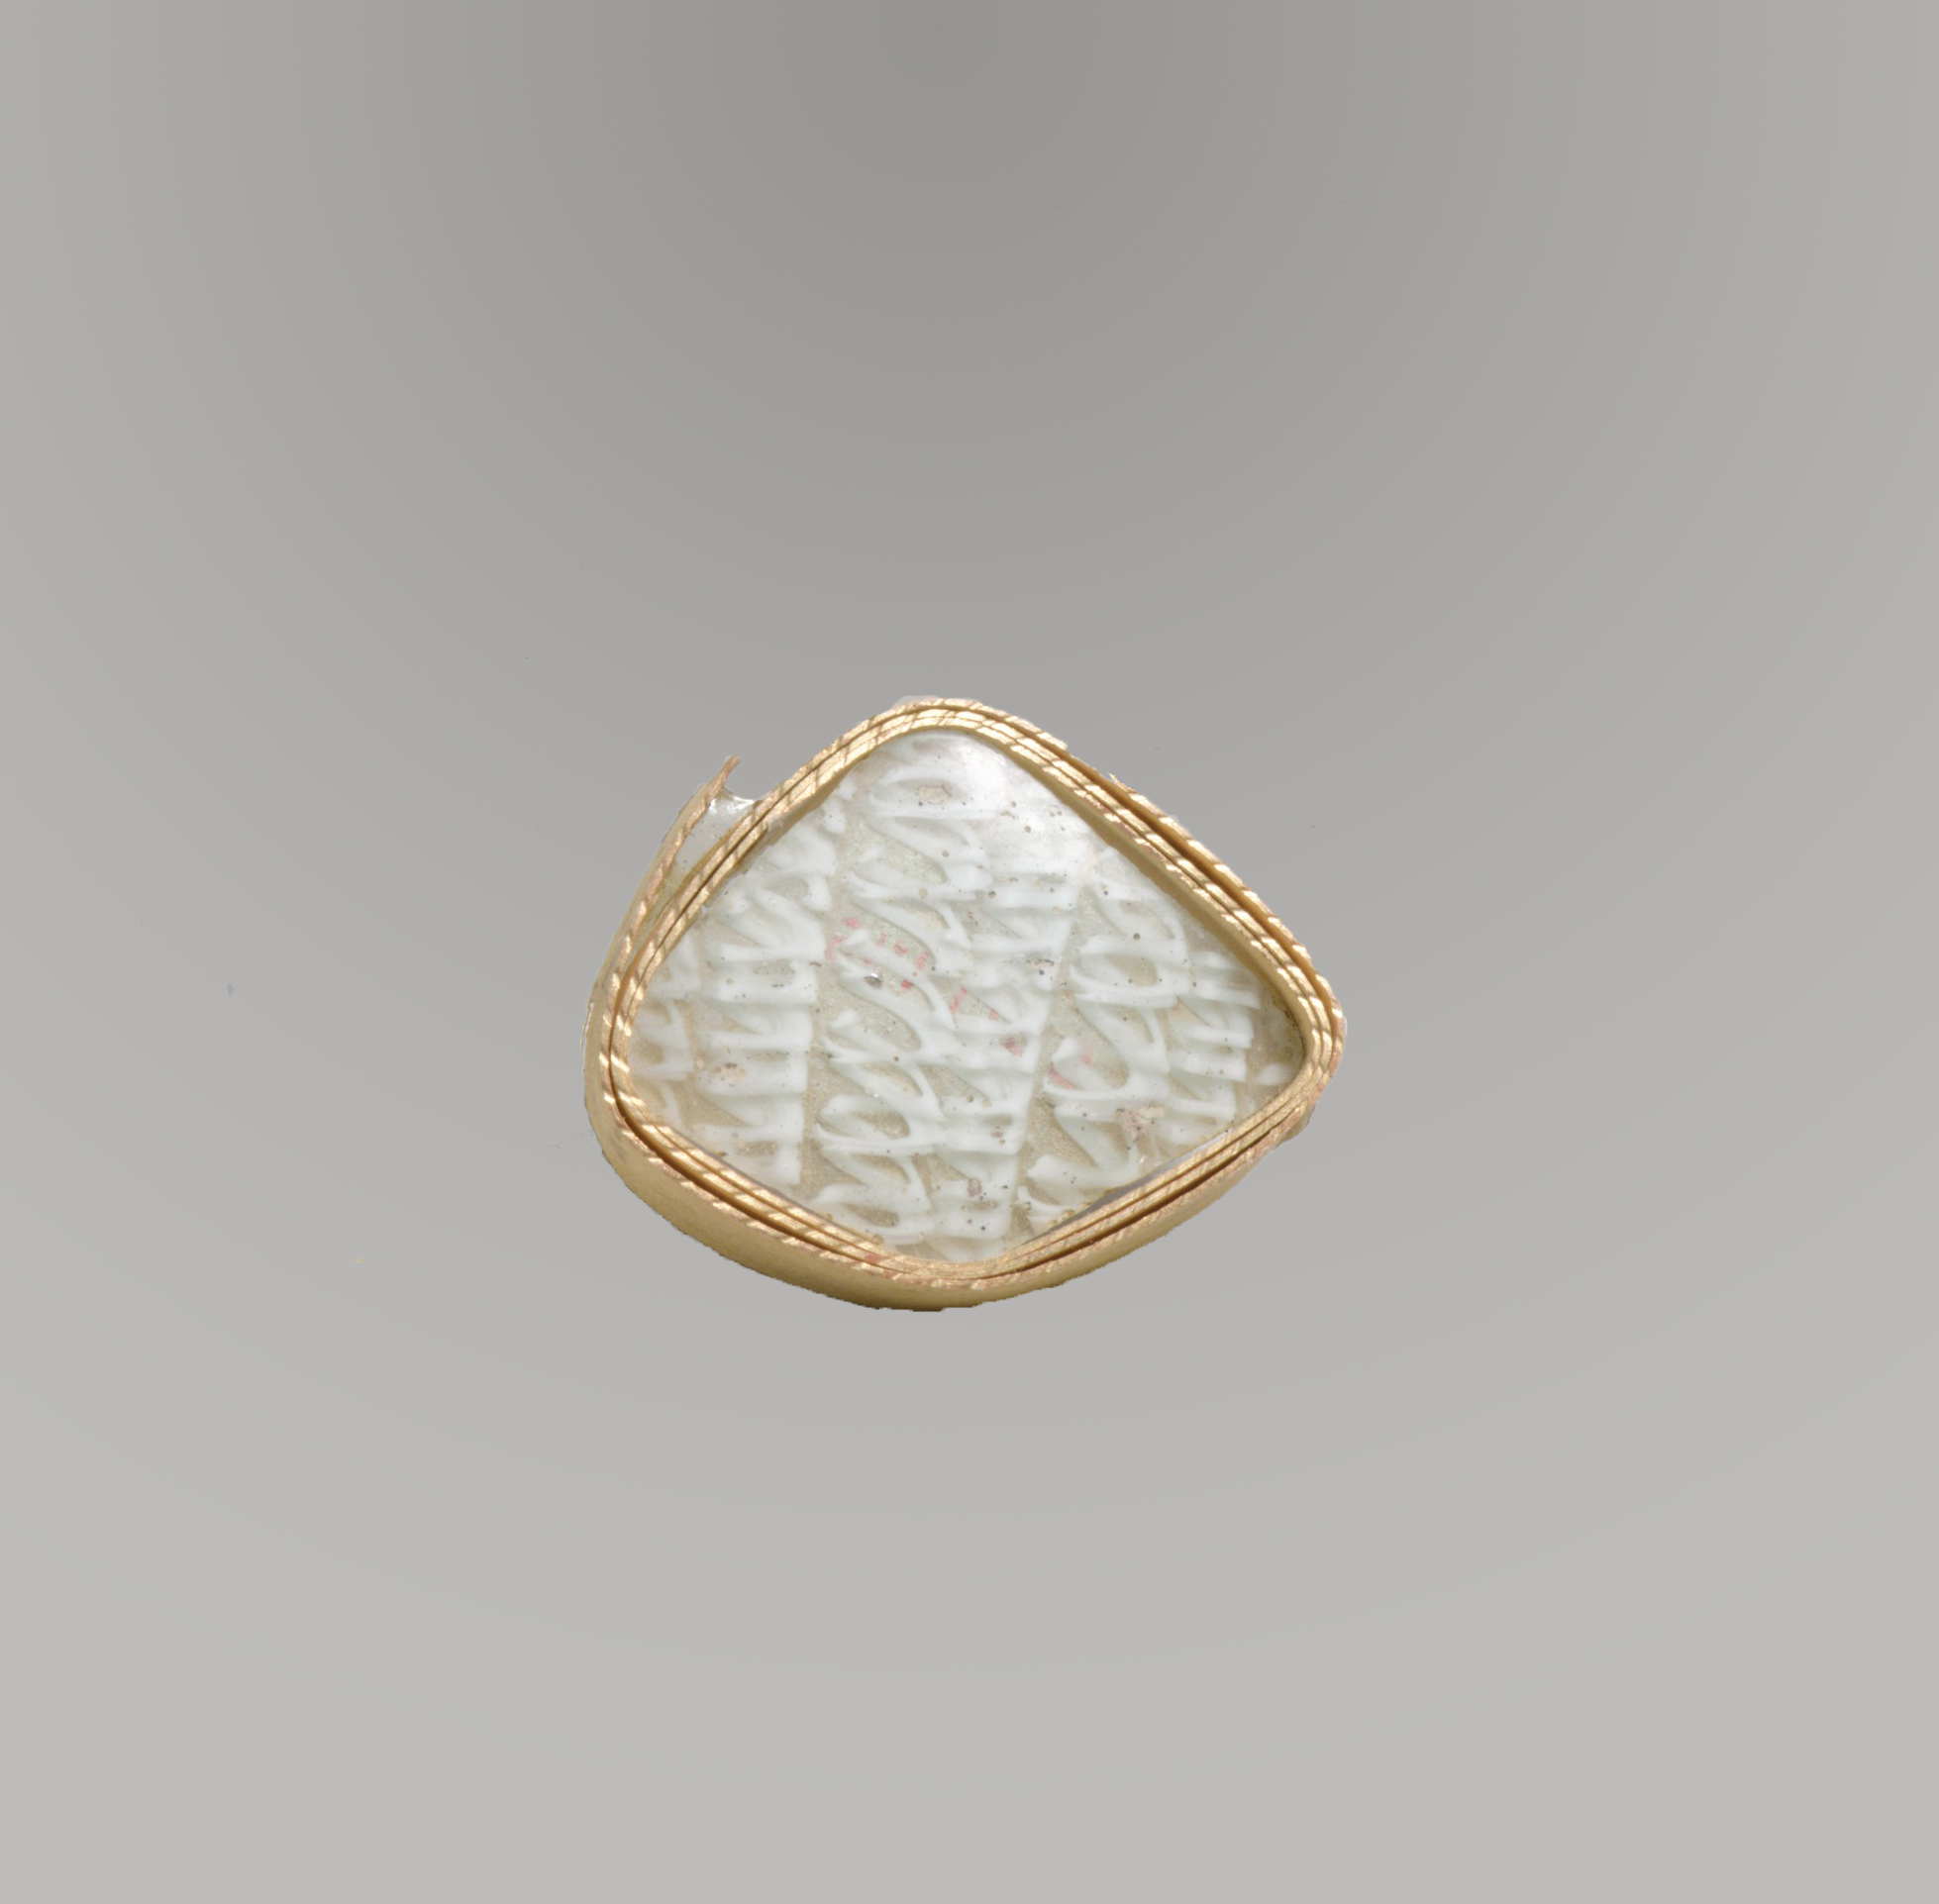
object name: fragment, network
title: Glass network mosaic fragment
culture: roman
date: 34 BCE-33 CE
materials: glass